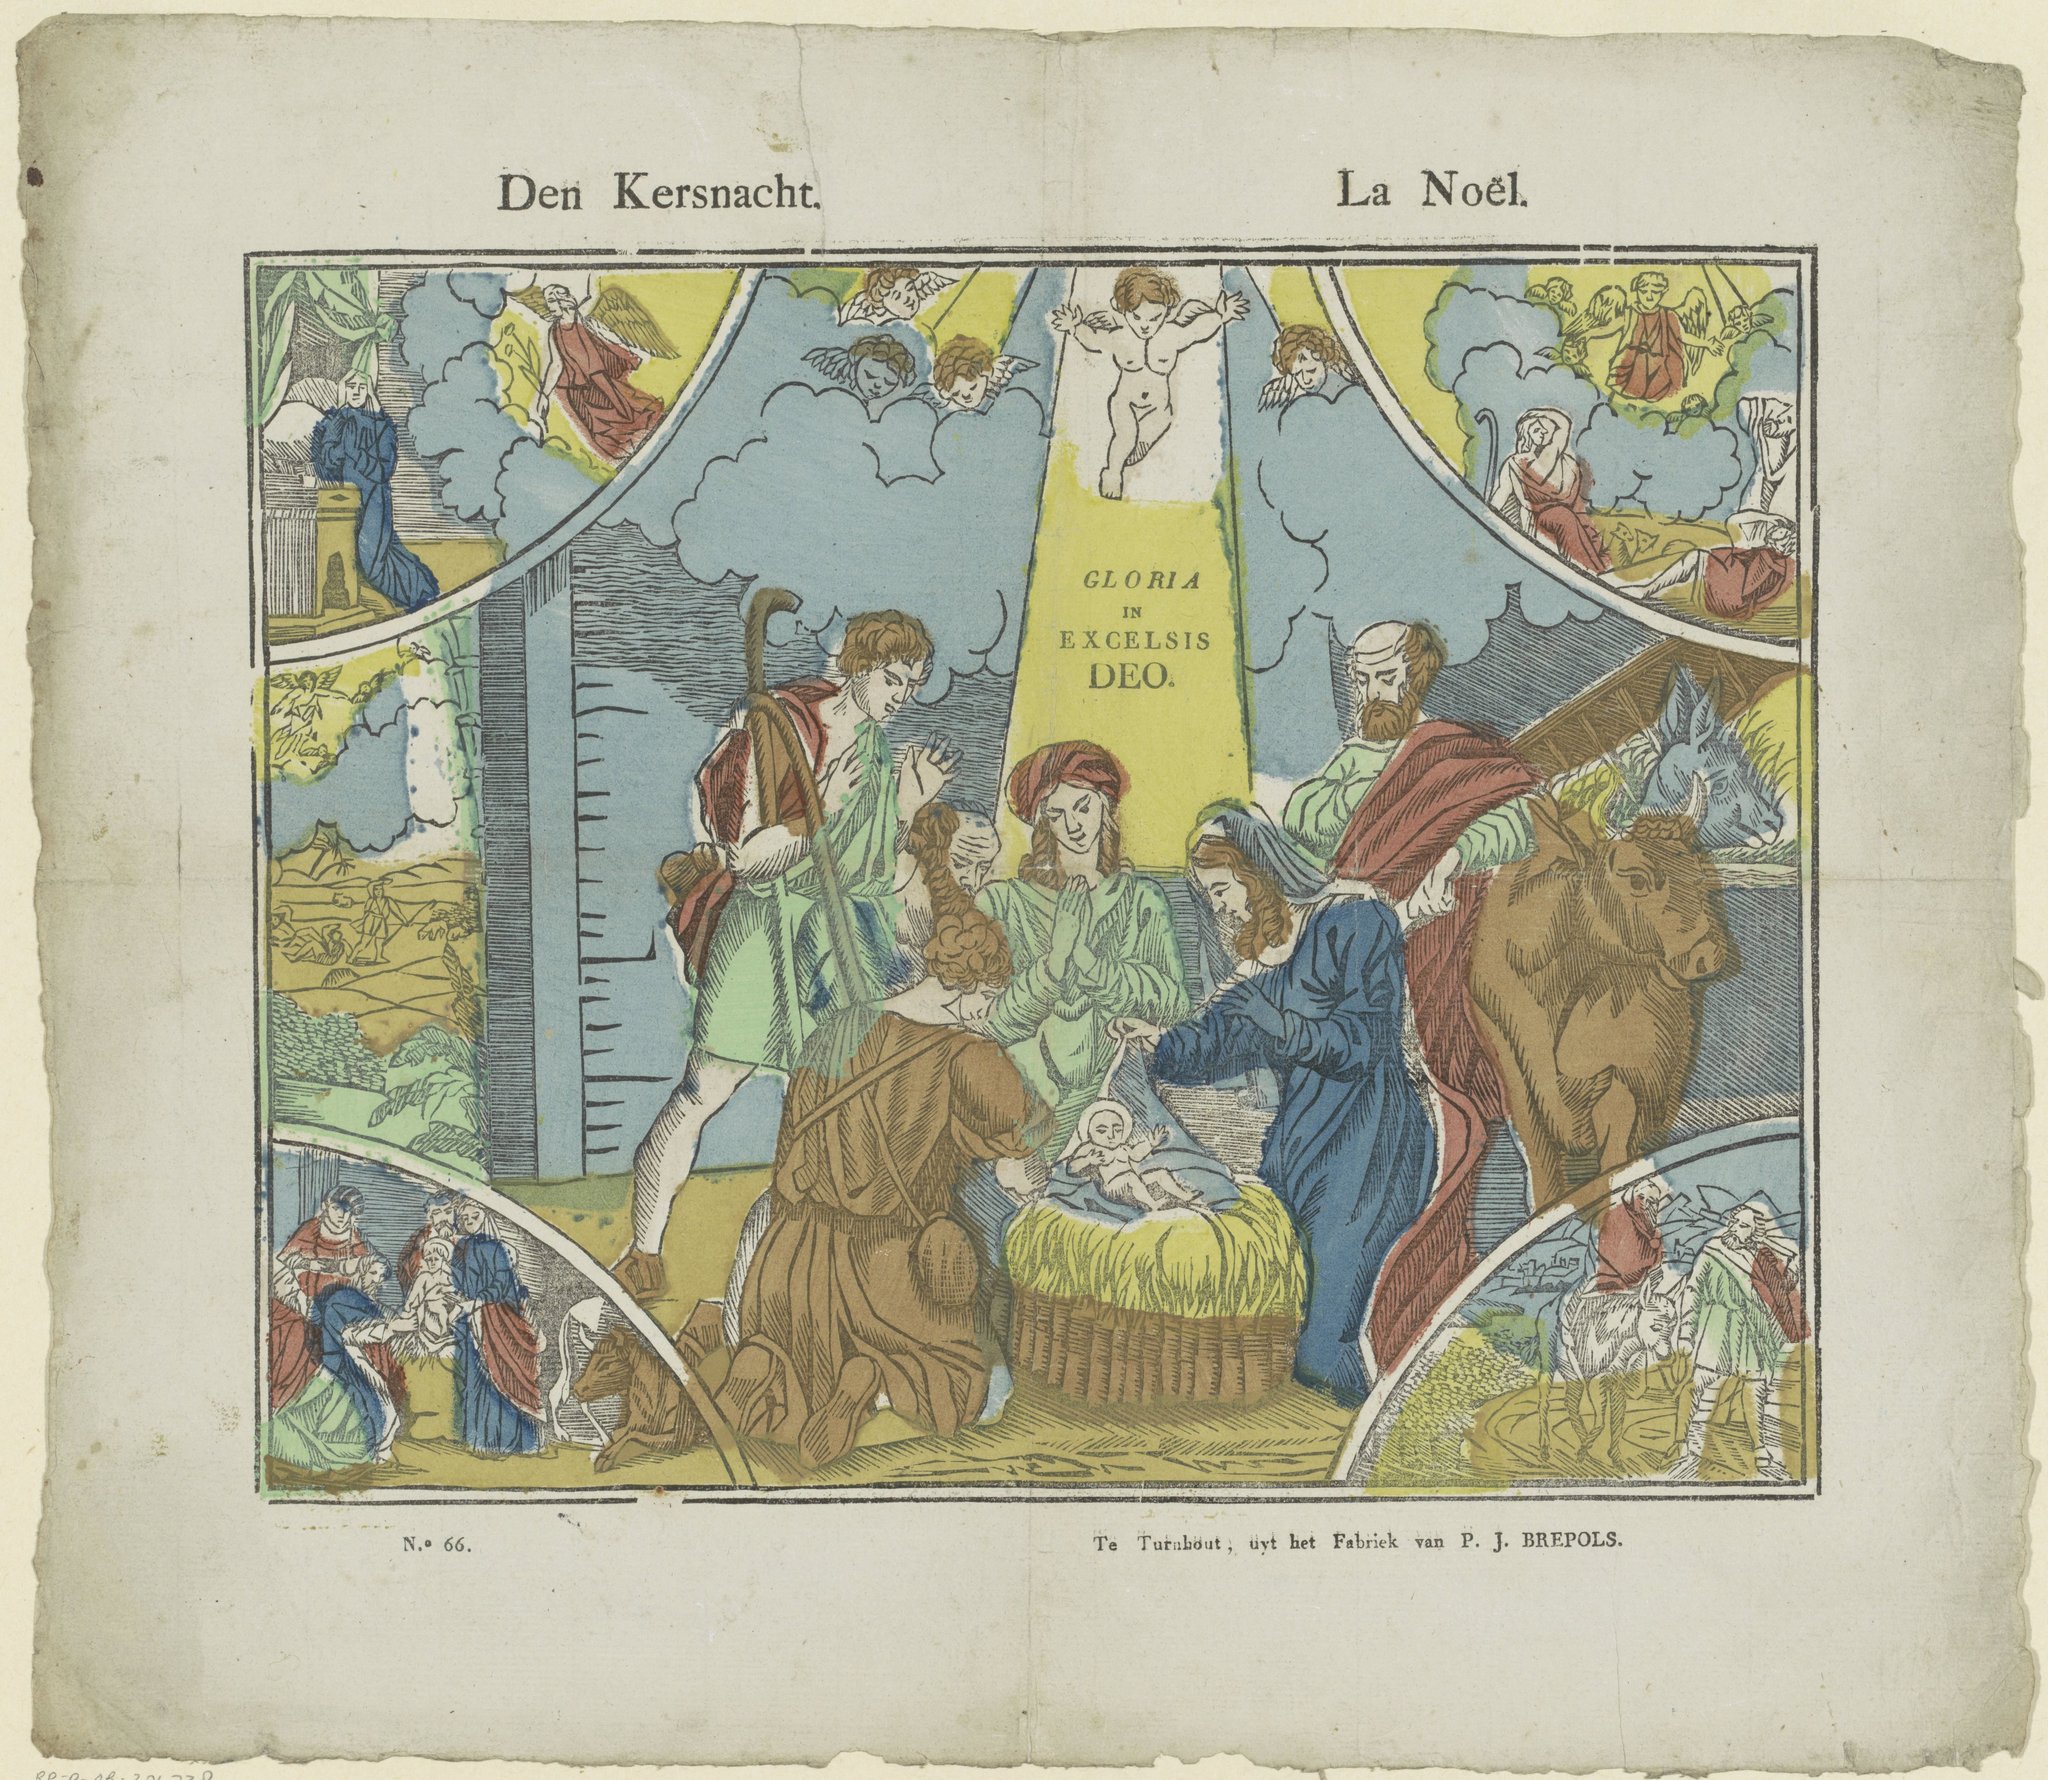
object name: popular print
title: Den kersnacht / La Noël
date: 1800-1833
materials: paper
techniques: colour, letterpress printing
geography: turnhout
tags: adoration of the christ-child by the shepherds; mary and joseph present, the annunciation: mary kneeling, annunciation of christ's birth to the shepherds (and/or shepherdesses) at night; a host of singing angels in the air, adoration of the kings: the wise men present their gifts to the christ-child (gold, frankincense and myrrh), journey of mary and joseph to bethlehem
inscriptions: collector's mark: Lugt 2760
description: De aanbidding door de herders, met rechts de os en de ezel. In een straal van licht de tekst 'Gloria in excelsis deo'. In de vier hoeken voorstellingen van de Annunciatie, de verkondiging aan de herders, de aanbidding door de koningen en de tocht naar Bethlehem. Genummerd linksonder: No. 66.